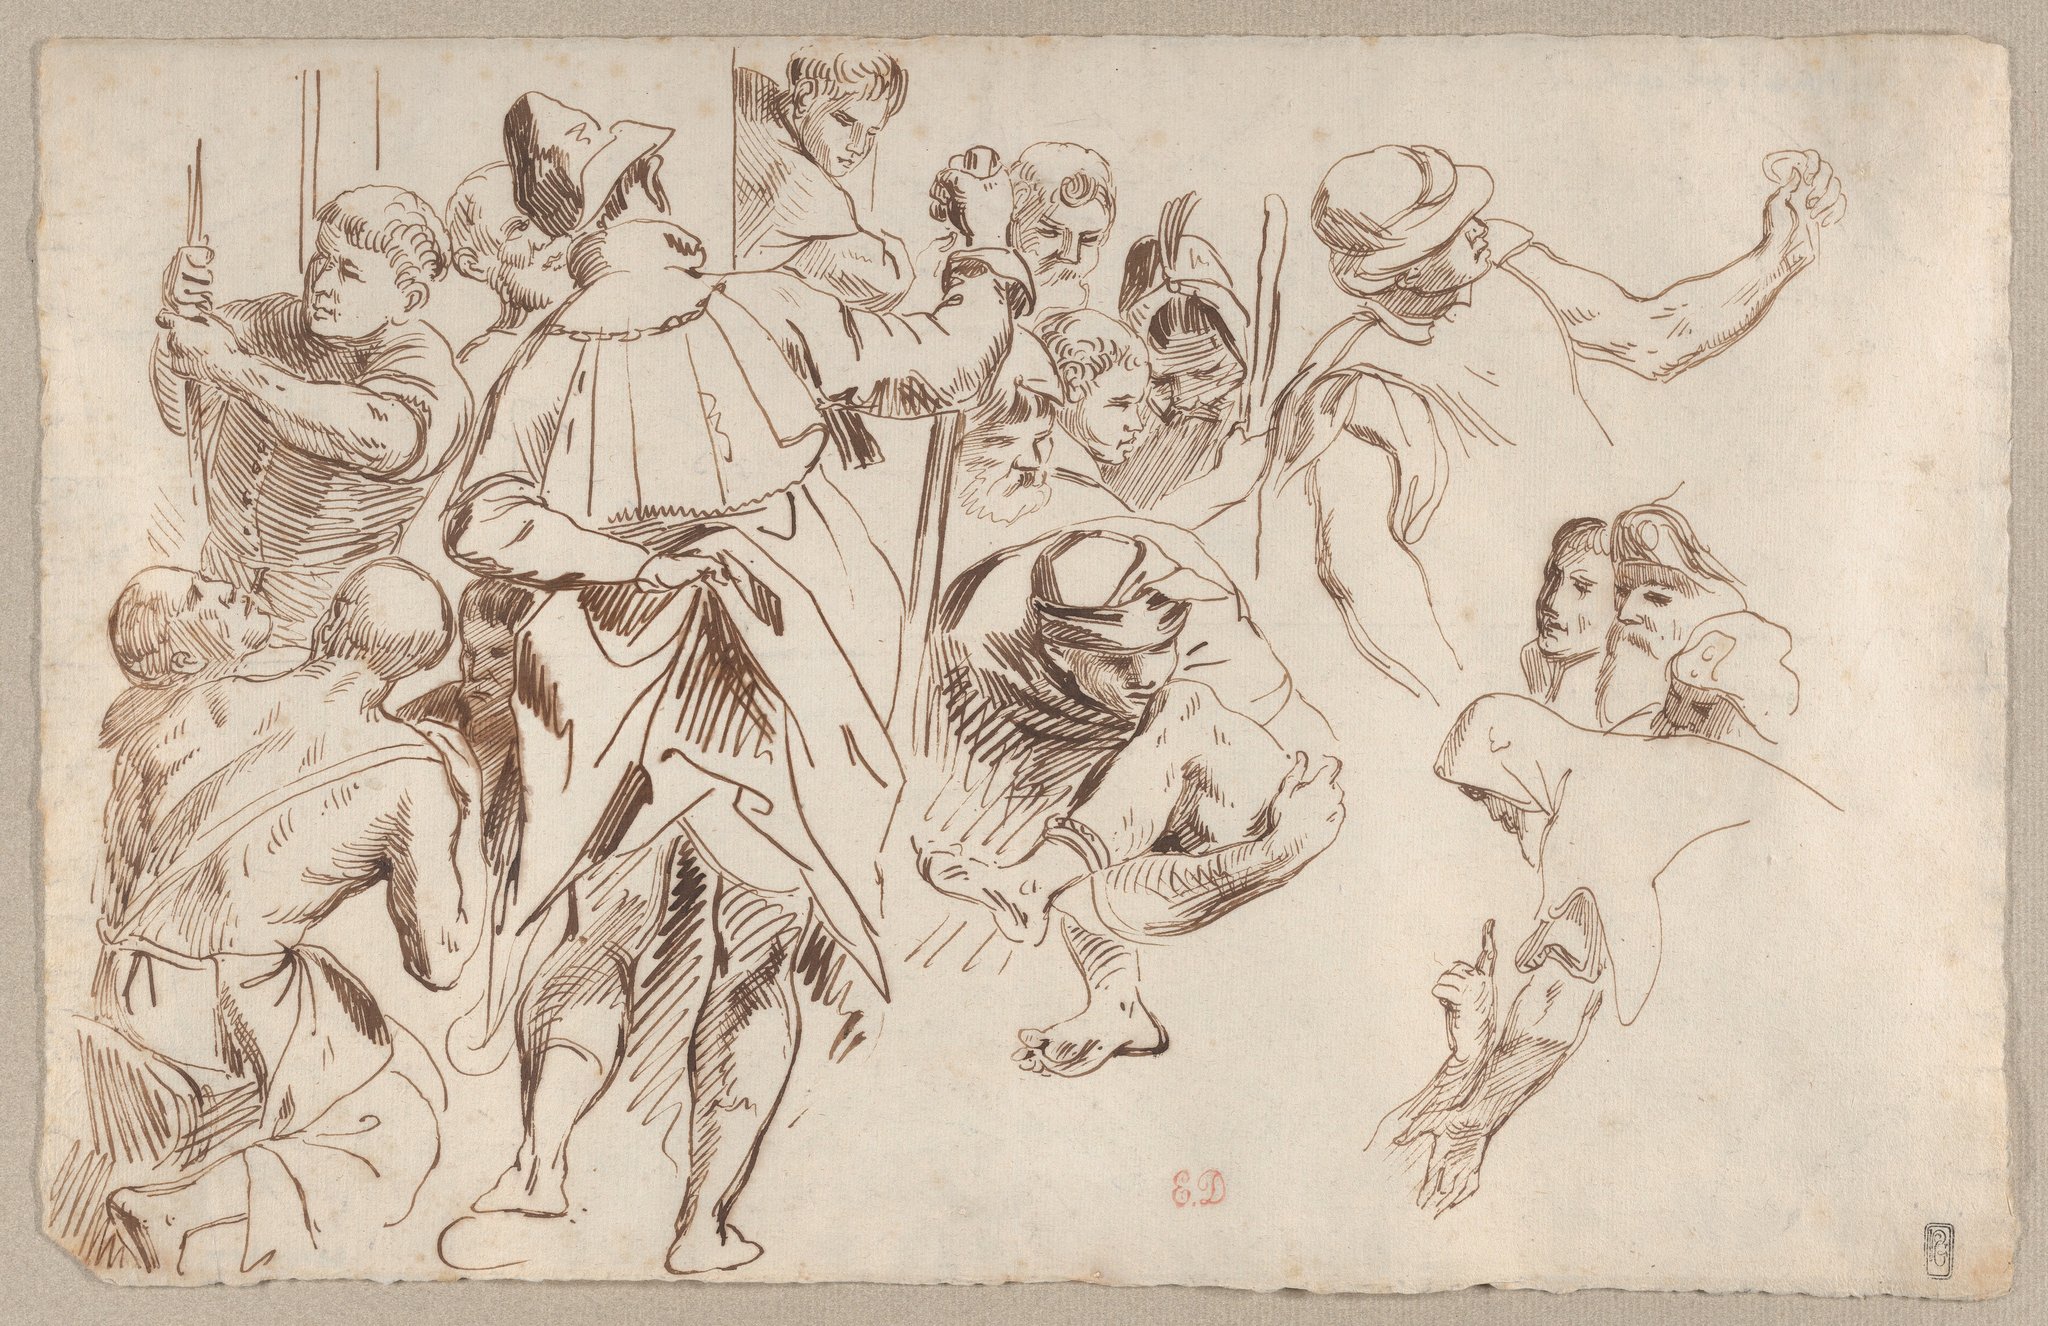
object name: drawing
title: Figure Studies after Veronese's "The Martyrdom of Saint Sebastian"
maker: eugène delacroix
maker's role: artist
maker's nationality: french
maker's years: 1798-1863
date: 1820-1829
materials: ink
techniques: pen